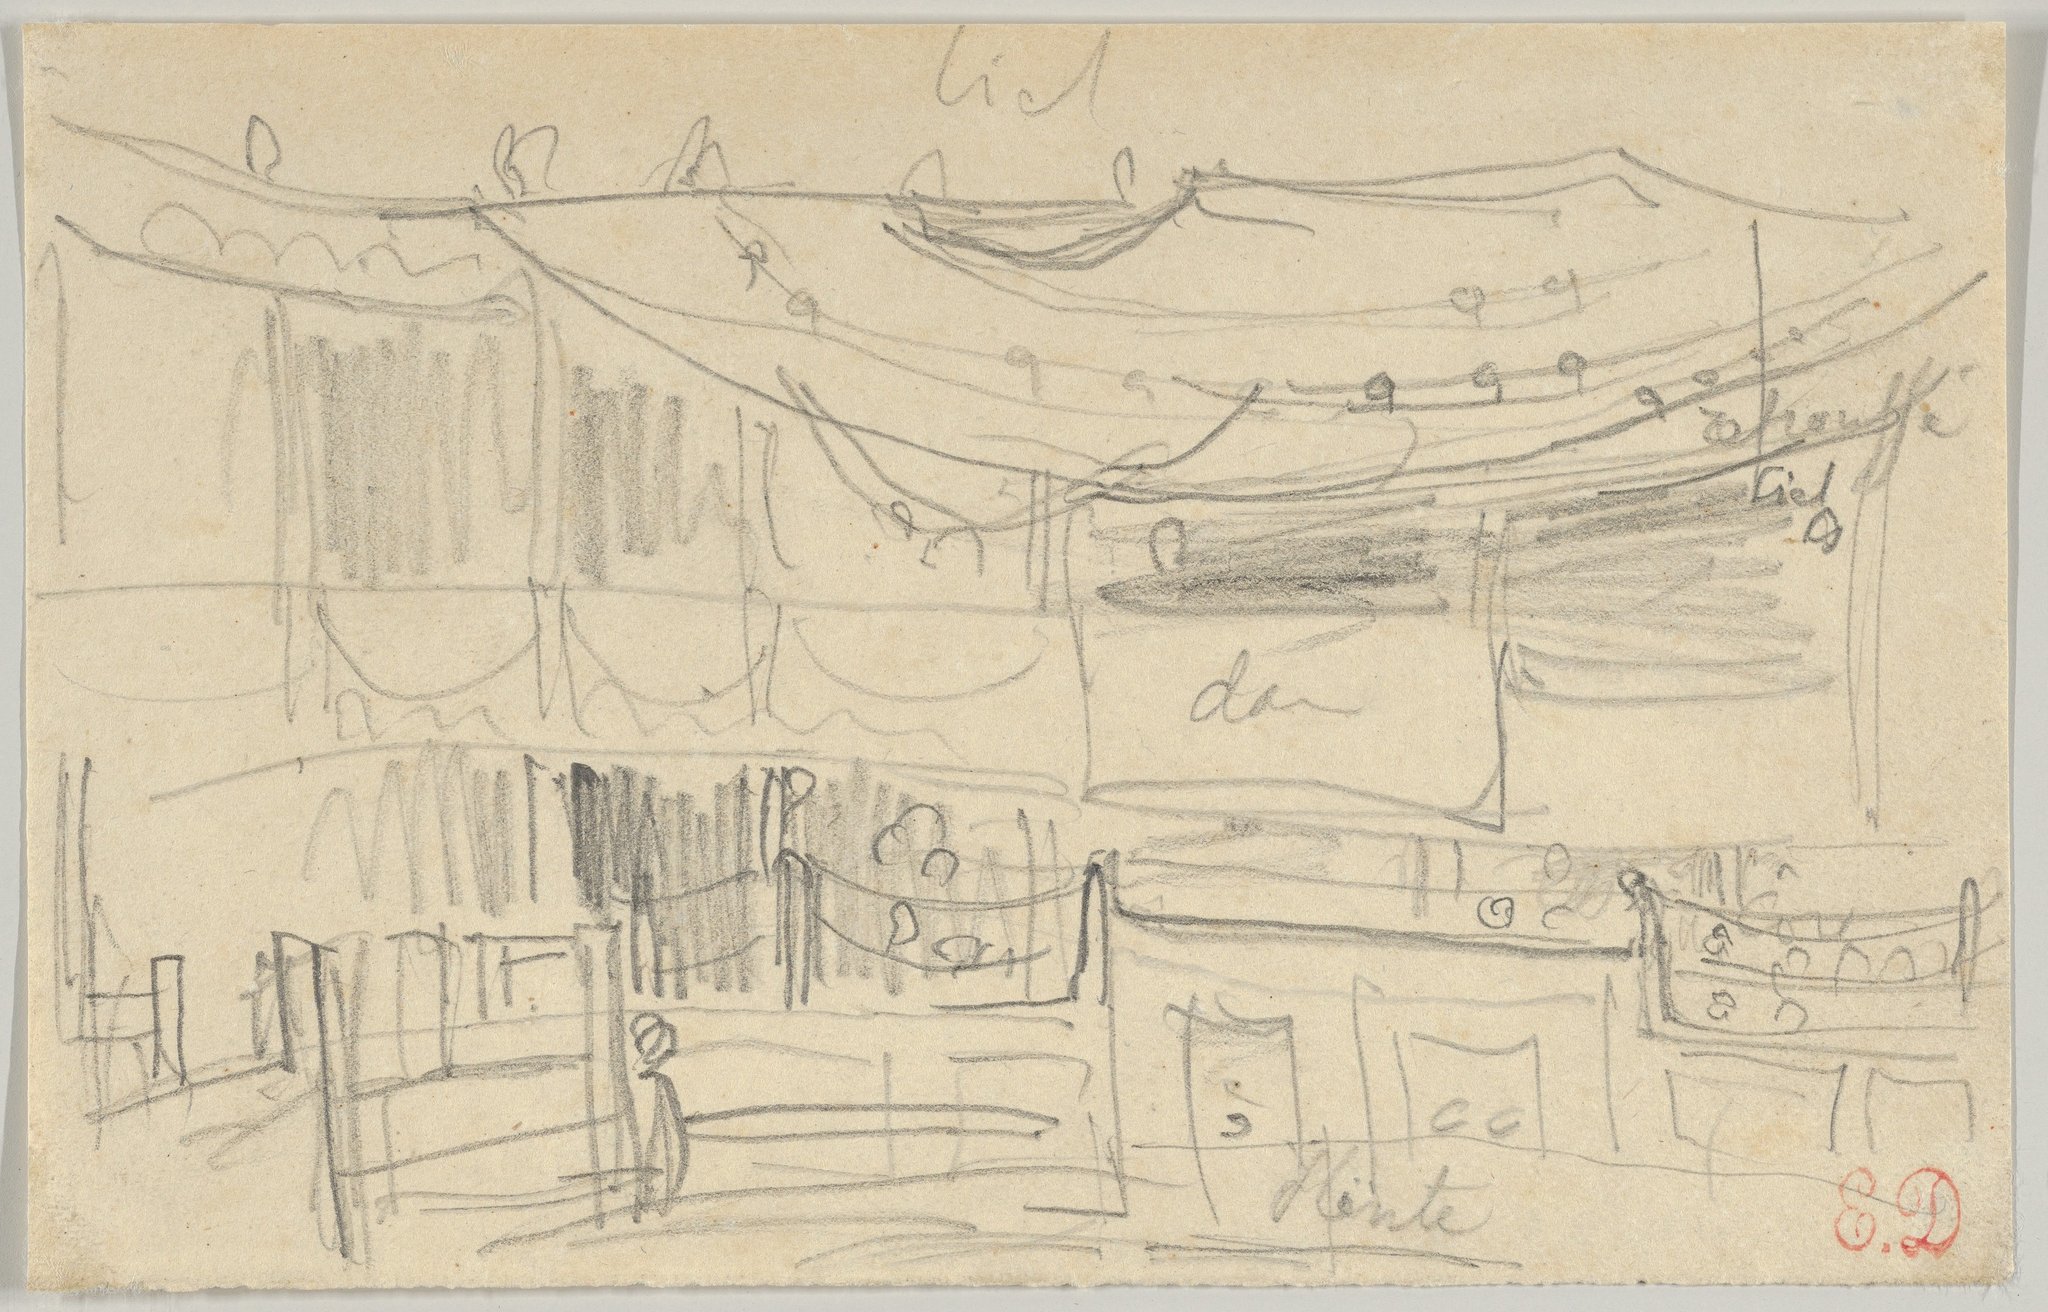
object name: drawing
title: Sketch of an Arena(?)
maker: eugène delacroix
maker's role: artist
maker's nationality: french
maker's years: 1798-1863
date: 1832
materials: graphite